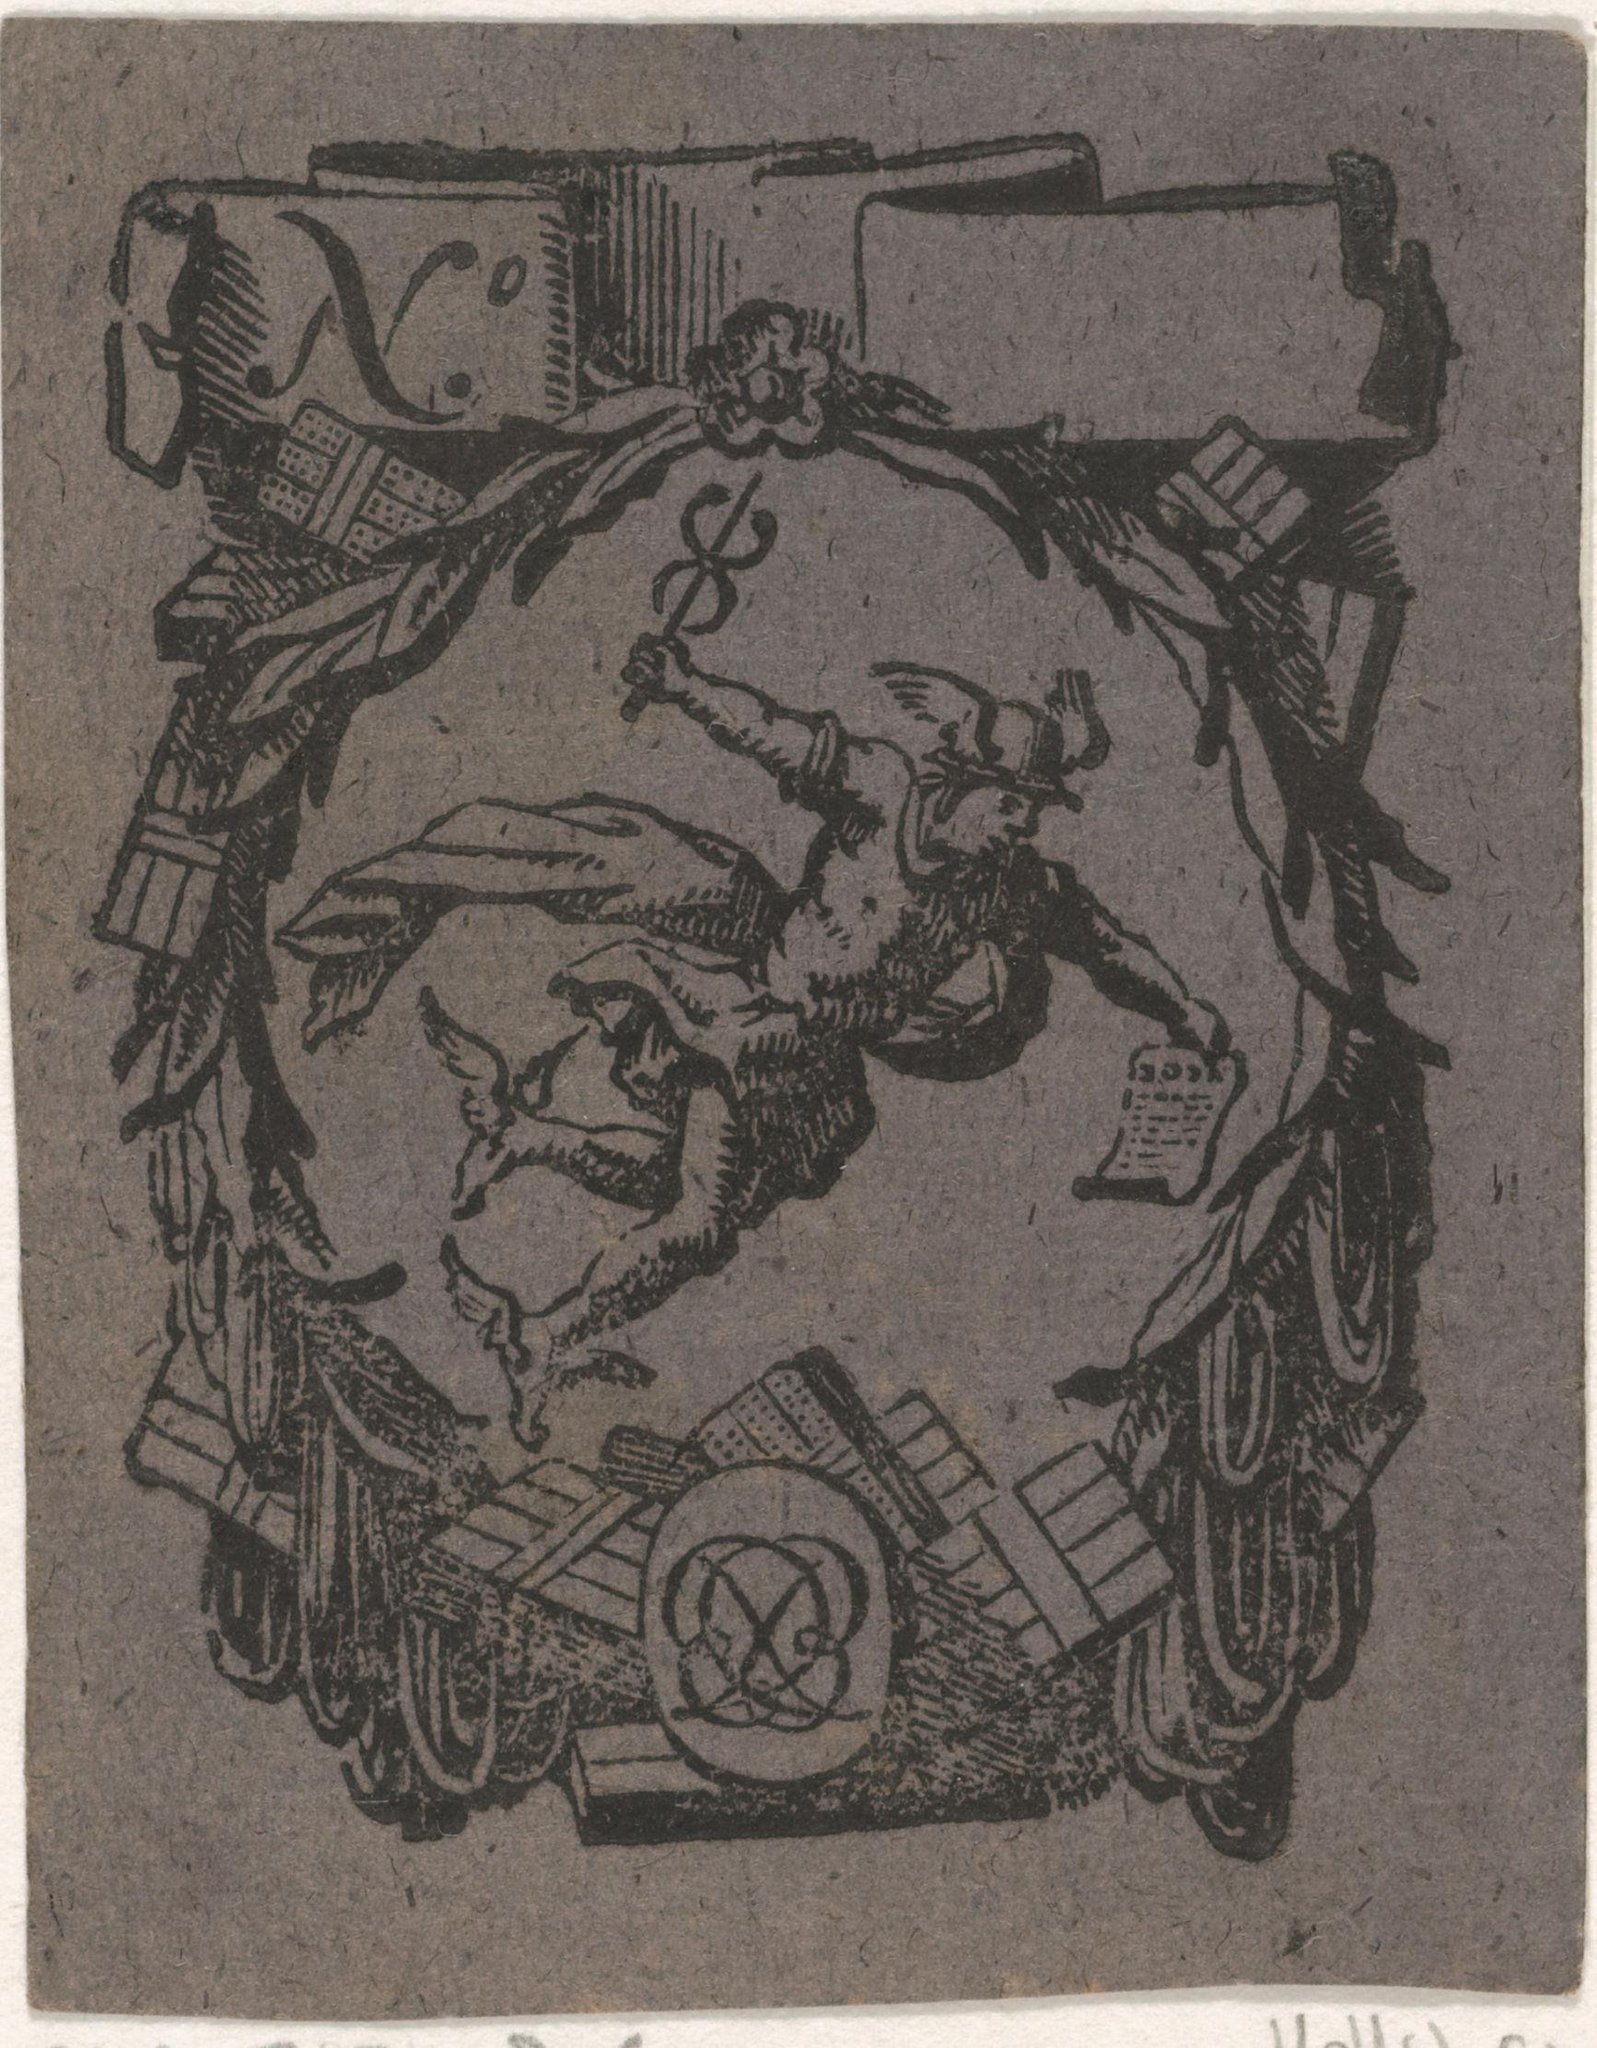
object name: print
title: Handelsetiket van David Barnaart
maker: isaac vincentsz. van der vinne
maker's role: draughtsman, print maker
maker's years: 1665-1740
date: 1681-1740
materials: paper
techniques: woodcut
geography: haarlem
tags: (story of) mercury (hermes), vignette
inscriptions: collector's mark: Lugt 240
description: Mercurius in een omlijsting van objecten. Midden onder het monogram van David Barnaart.